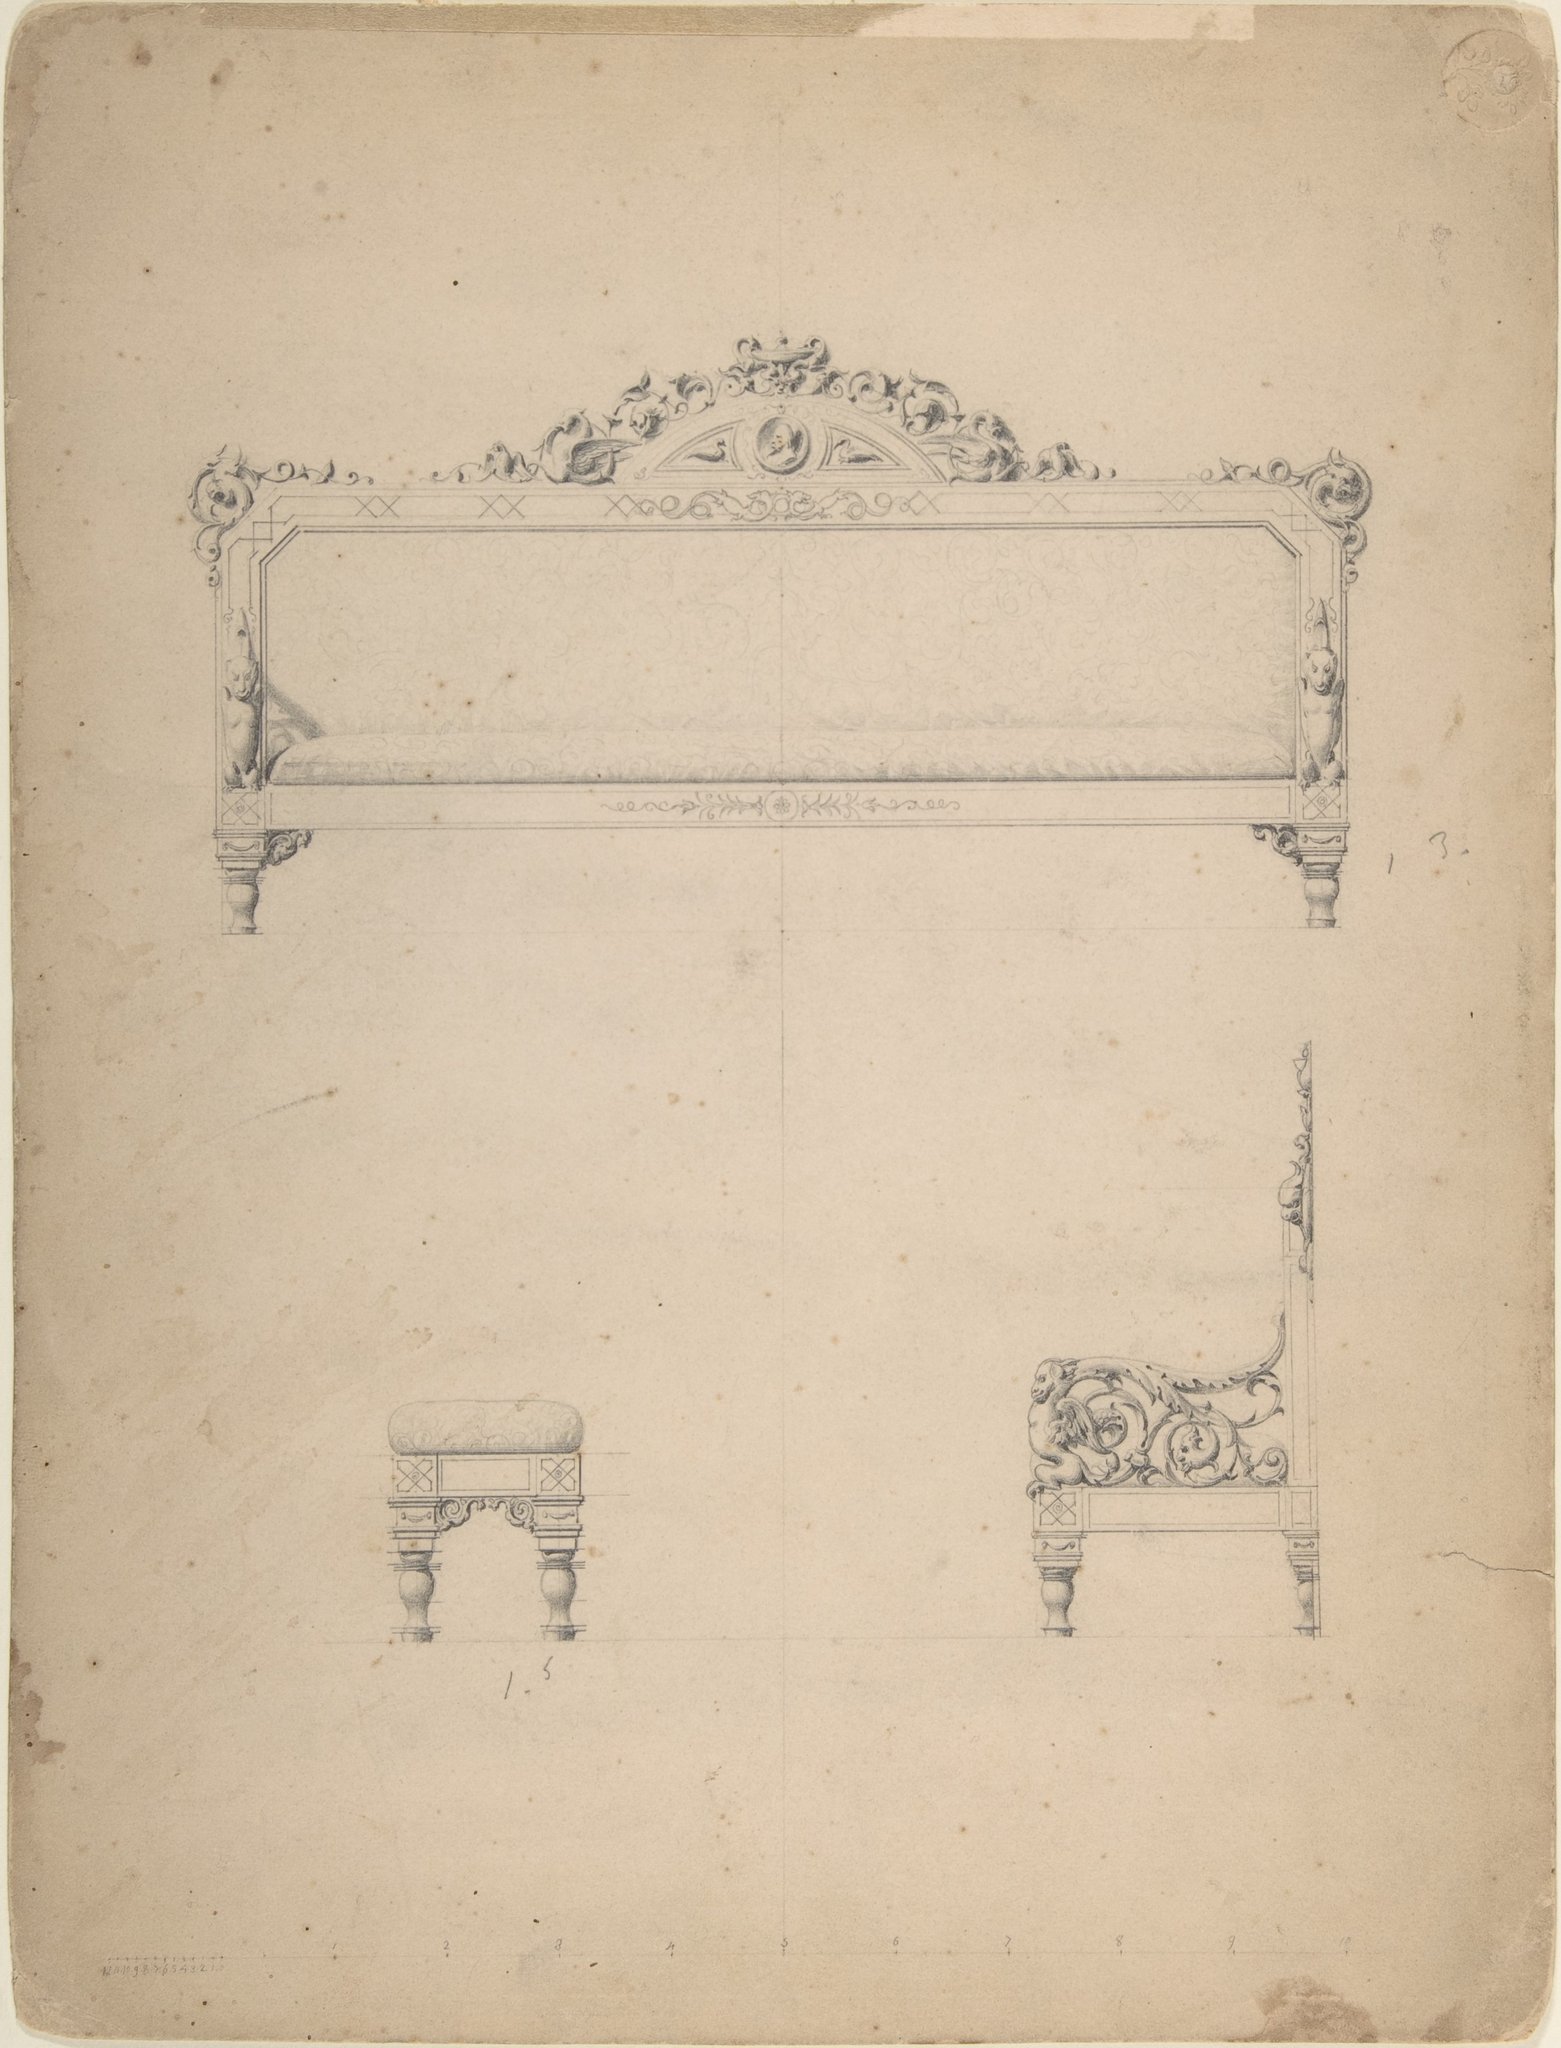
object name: drawing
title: Designs for Couch, Chair, and Stool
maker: anonymous, italian, 19th century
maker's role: artist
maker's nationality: italian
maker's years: 1800-1900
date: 1800-1900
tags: chairs,couches,stools